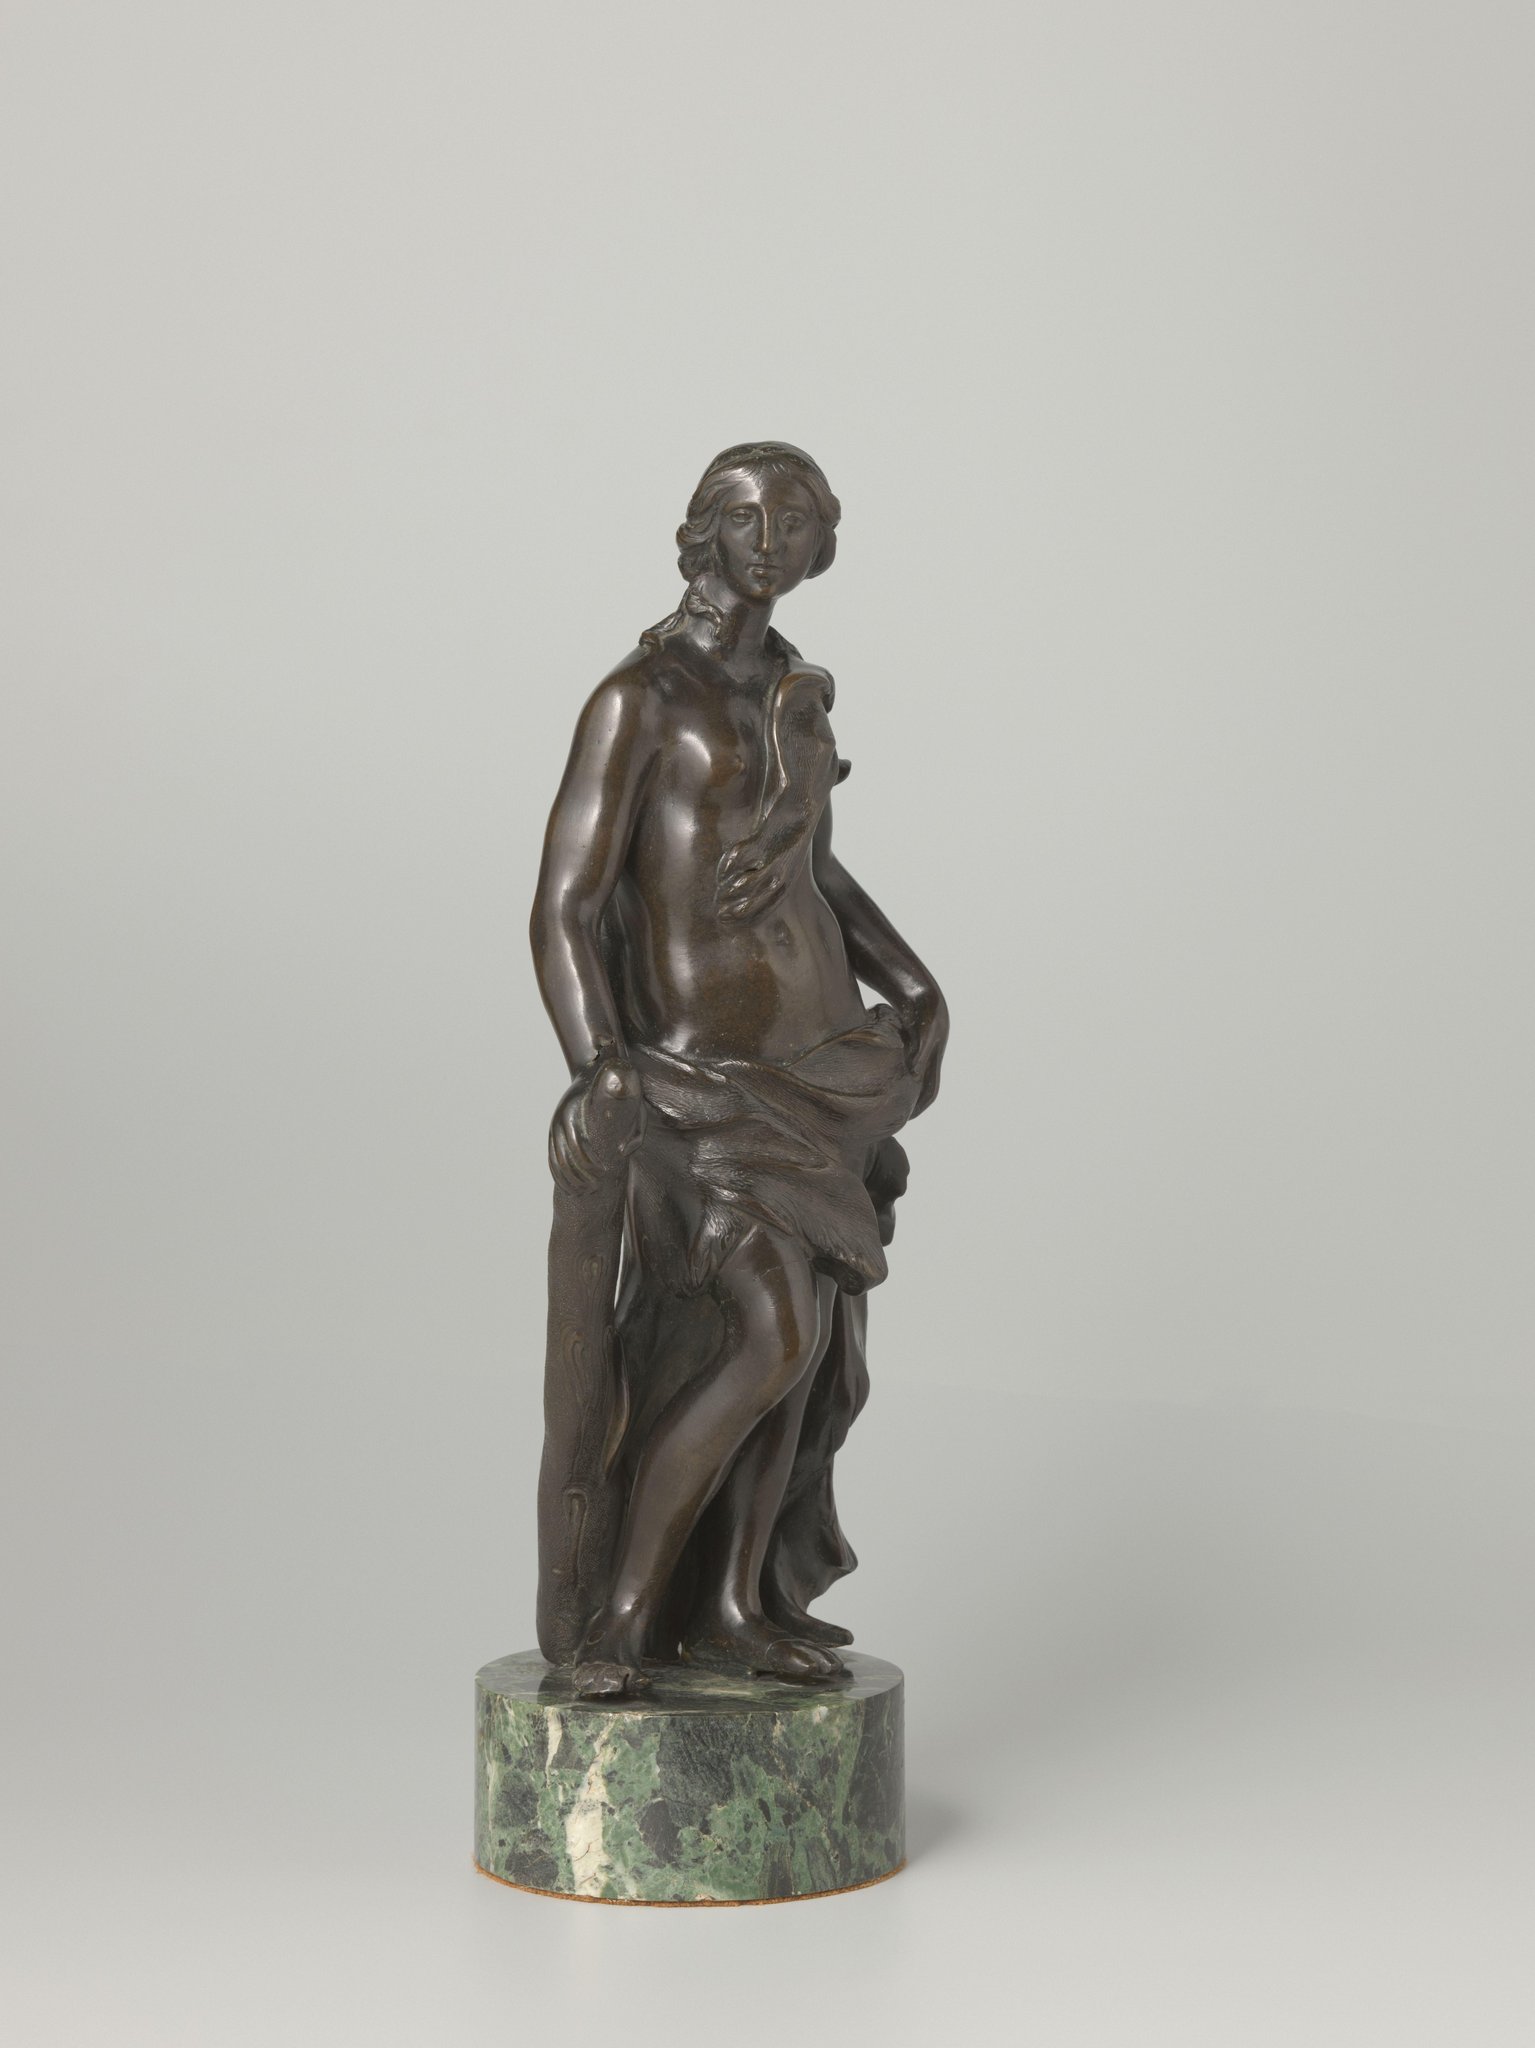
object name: sculpture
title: Omphale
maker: hubert le sueur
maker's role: sculptor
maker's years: 1580-1668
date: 1625-1641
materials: bronze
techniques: casting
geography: london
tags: hercules in love with omphale; the hero is set to spin wool or to do other women's work among the servants, while omphale wears his lion's skin and wields his club and bow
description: Omphale: vrouwenfiguur, gekleed in de leeuwenhuid van Hercules. Zij draagt de knots die achter haar op de grond rust. Haar haar zit in de nek in een wrong, met afhangende tressen tot op de schouders.